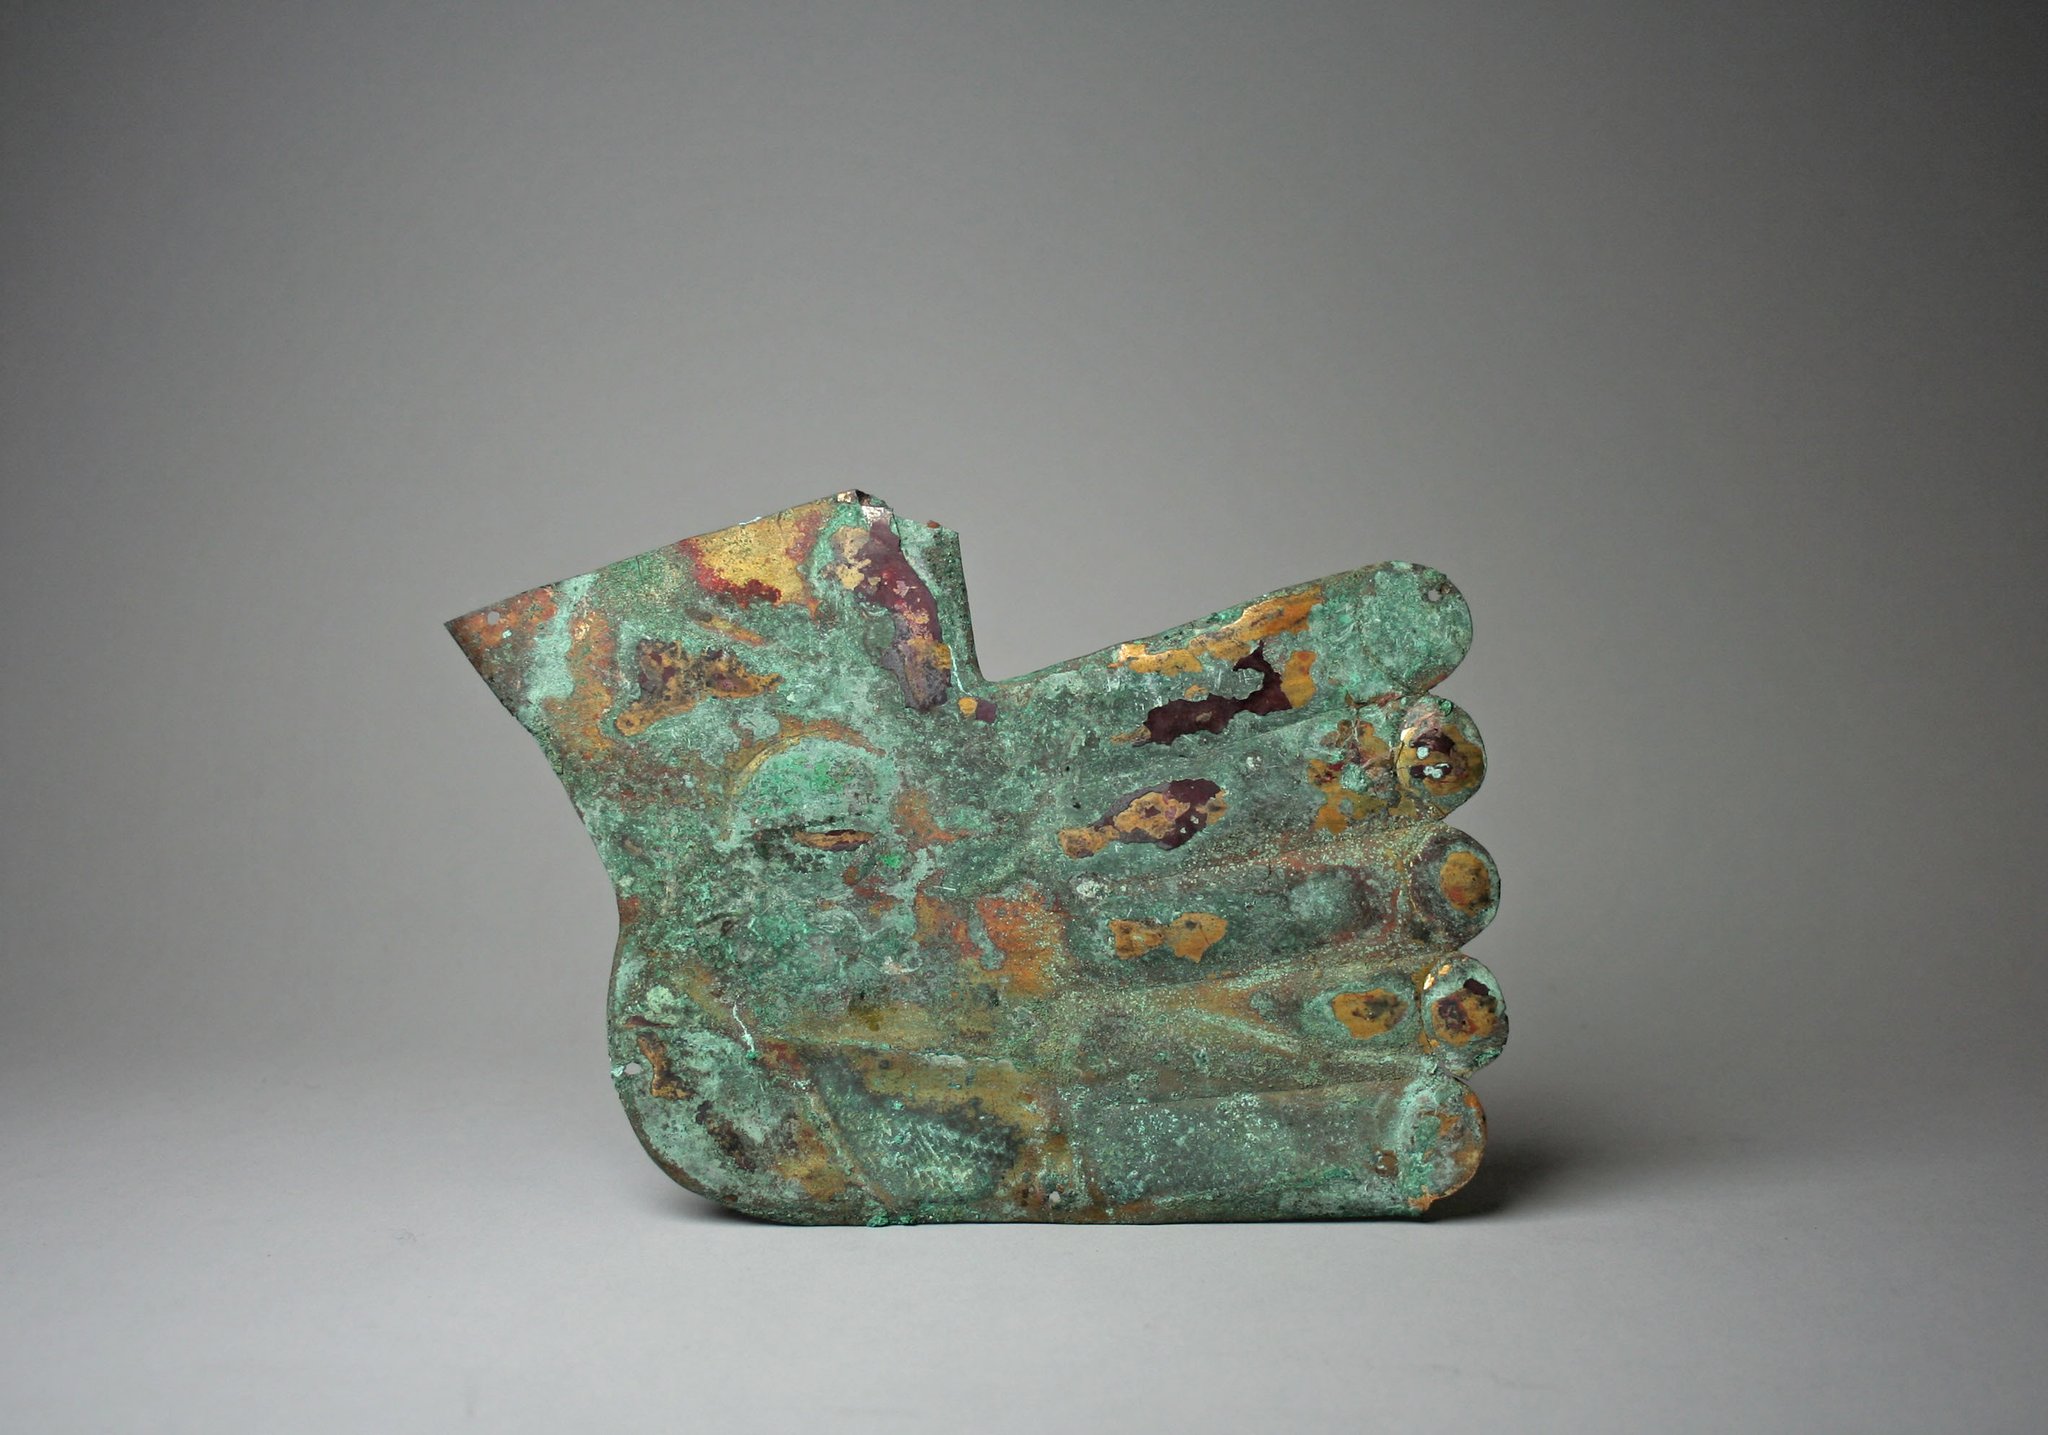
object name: ornament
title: Foot Ornament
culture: moche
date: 501-700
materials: metal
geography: peru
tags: feet